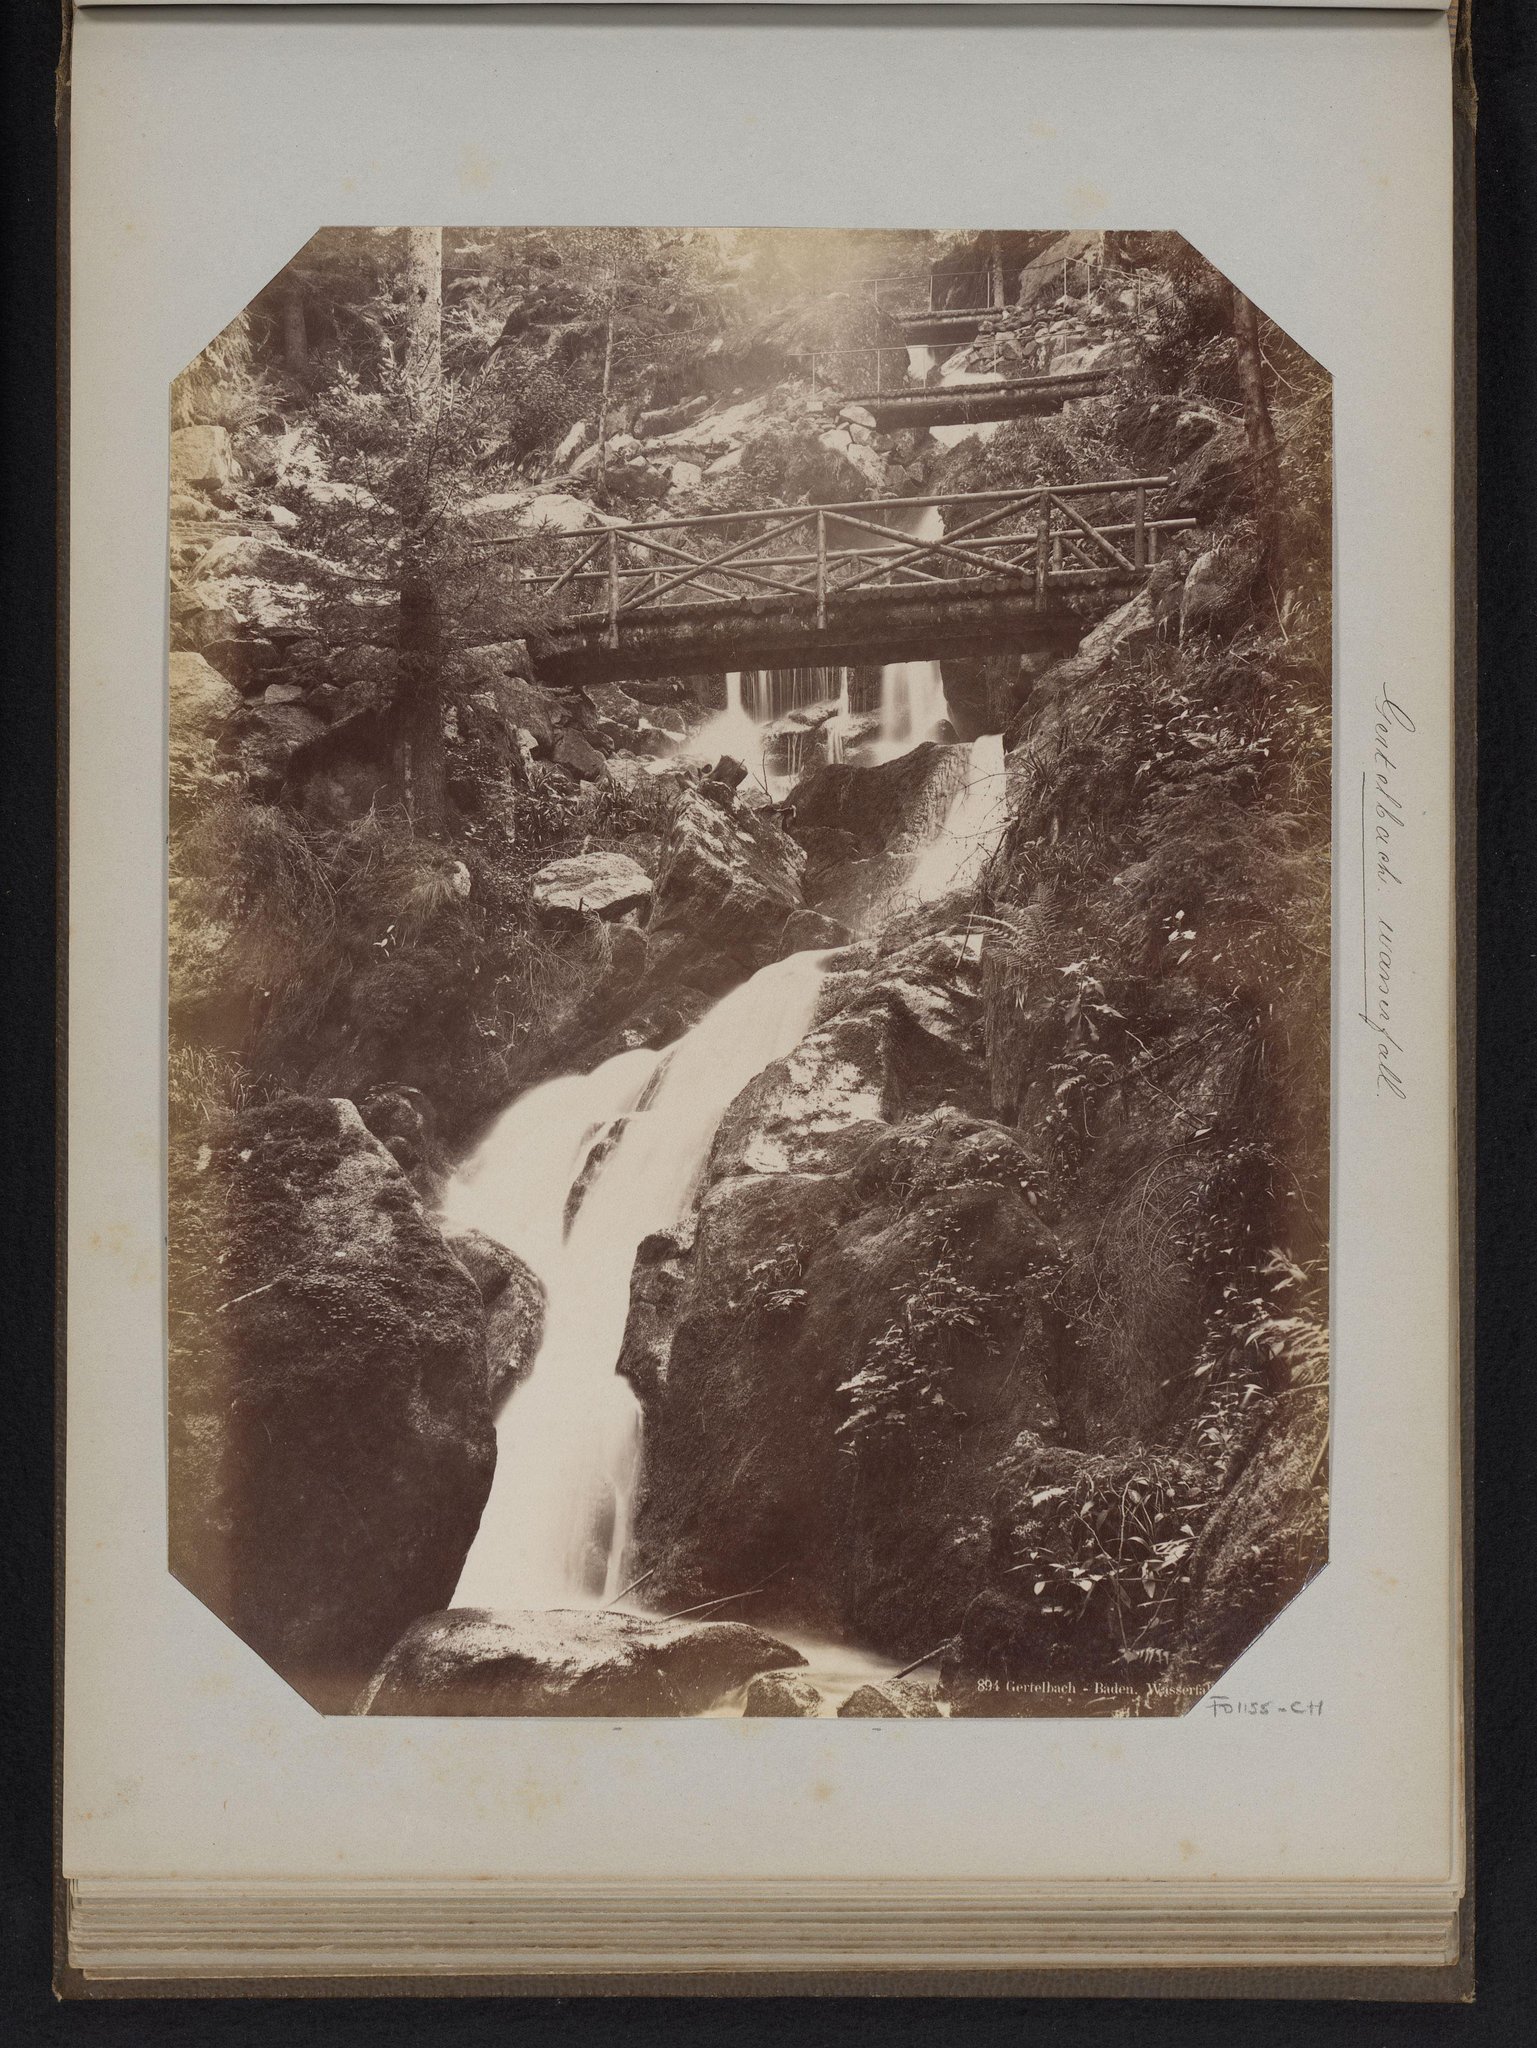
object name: album leaf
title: Gezicht op de Gertelbach Wasserfälle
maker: ll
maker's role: fotograaf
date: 1890-1899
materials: photographic support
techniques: albumen print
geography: baden-baden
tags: waterfall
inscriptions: inscription: ‘894 Gertelbach - Baden. Wasserfalle. L.L.’